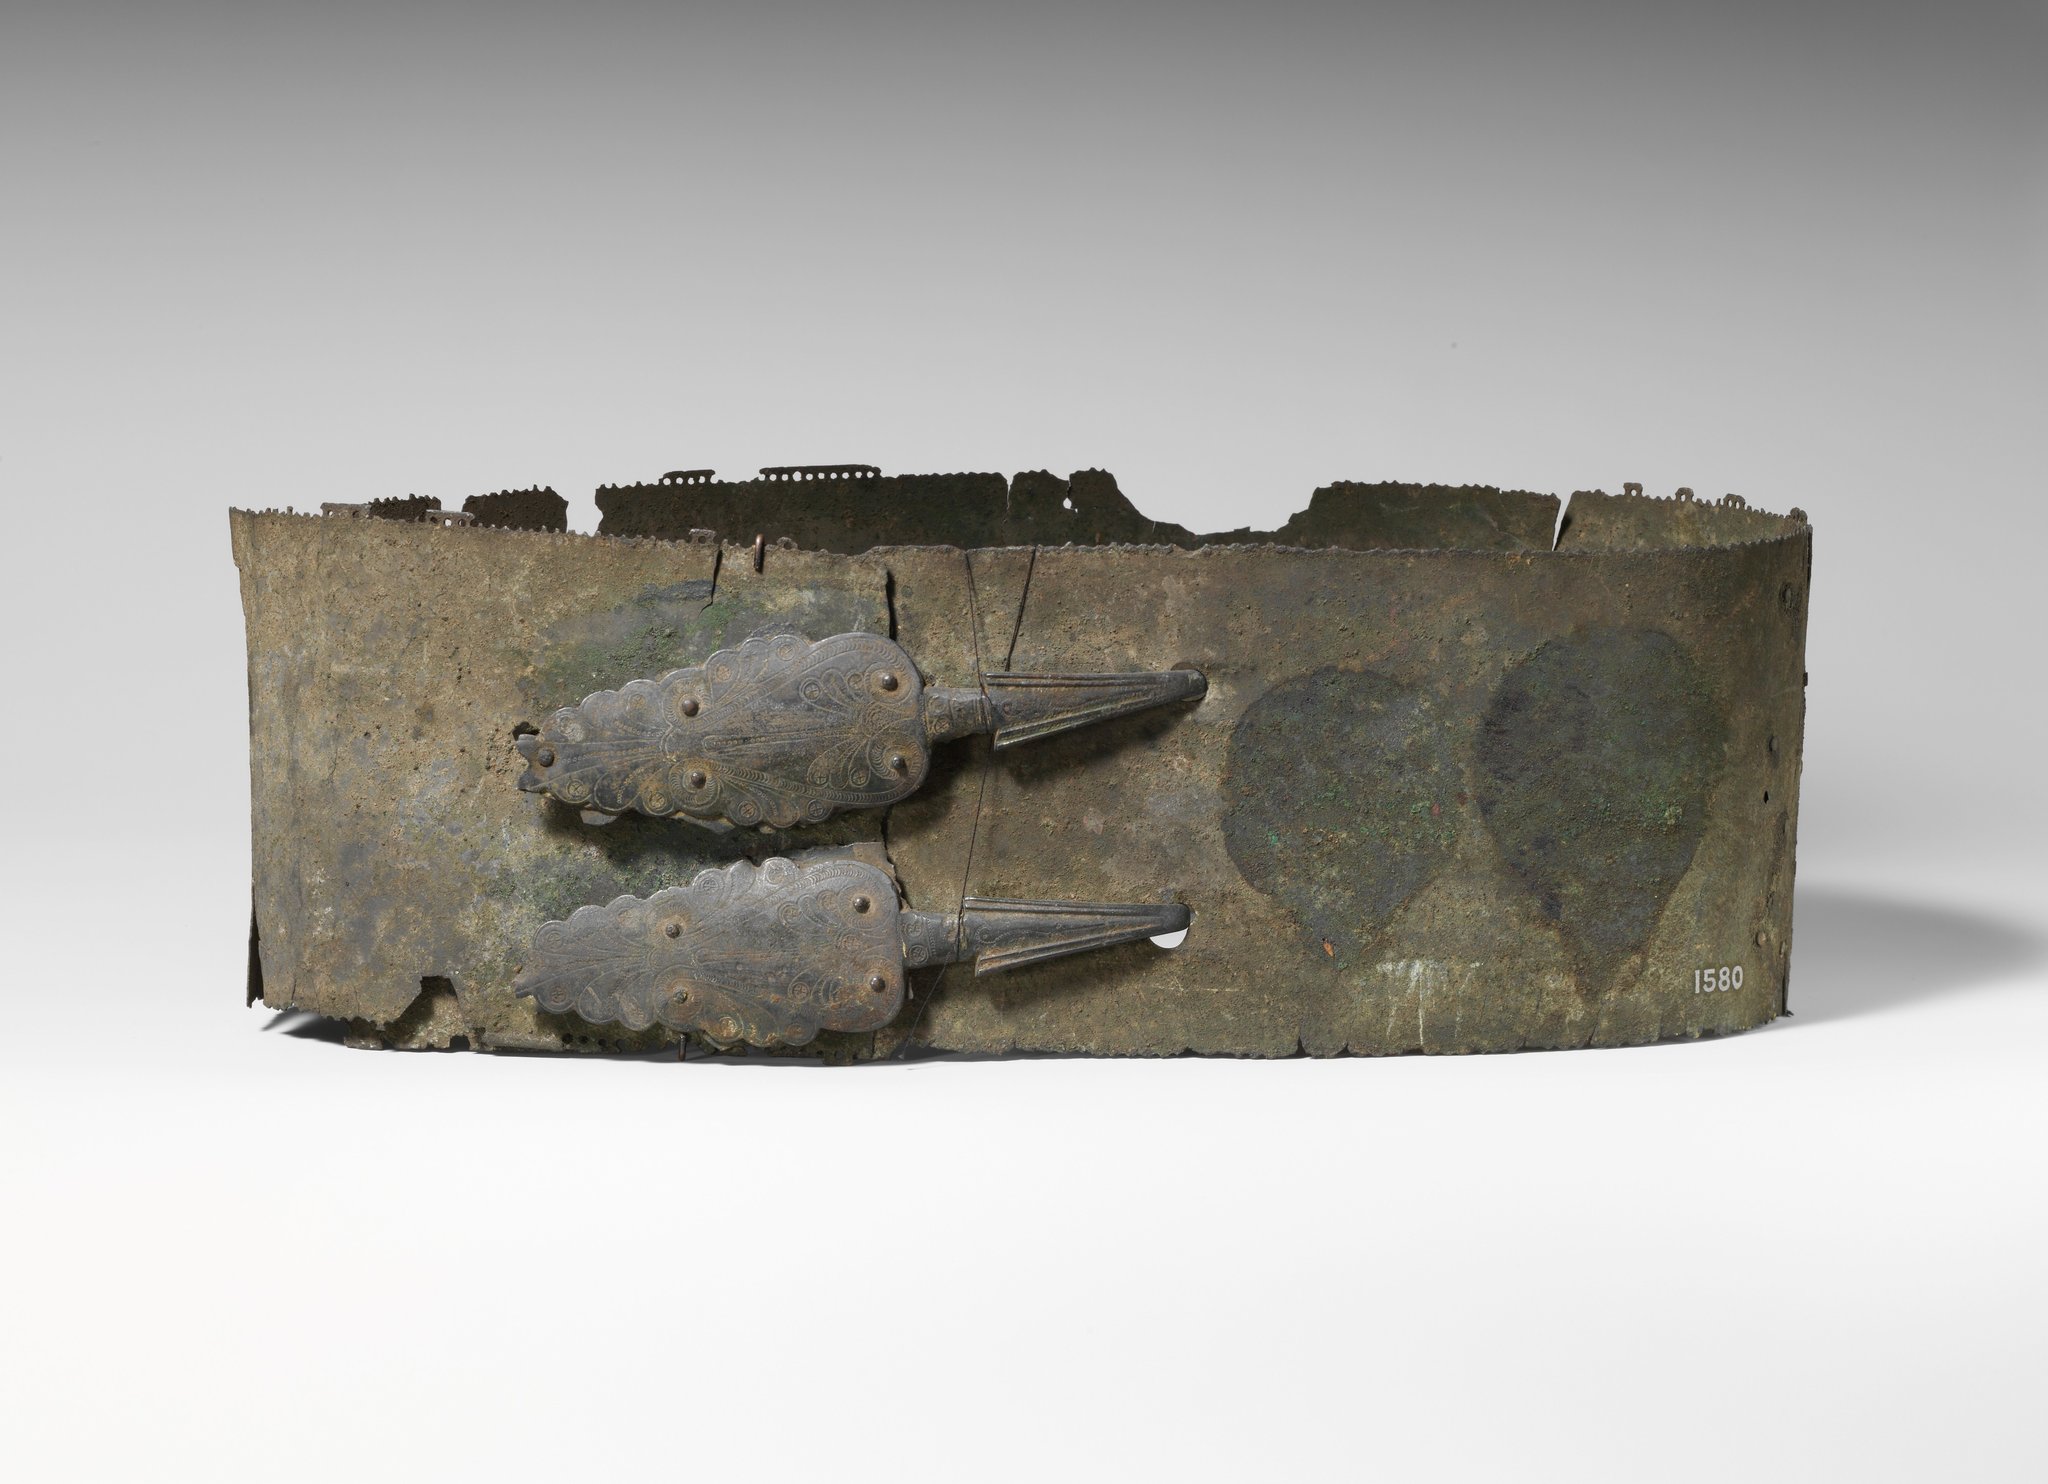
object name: belt clasp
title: Bronze belt and clasps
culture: italic, samnite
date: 434-368 BCE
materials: bronze